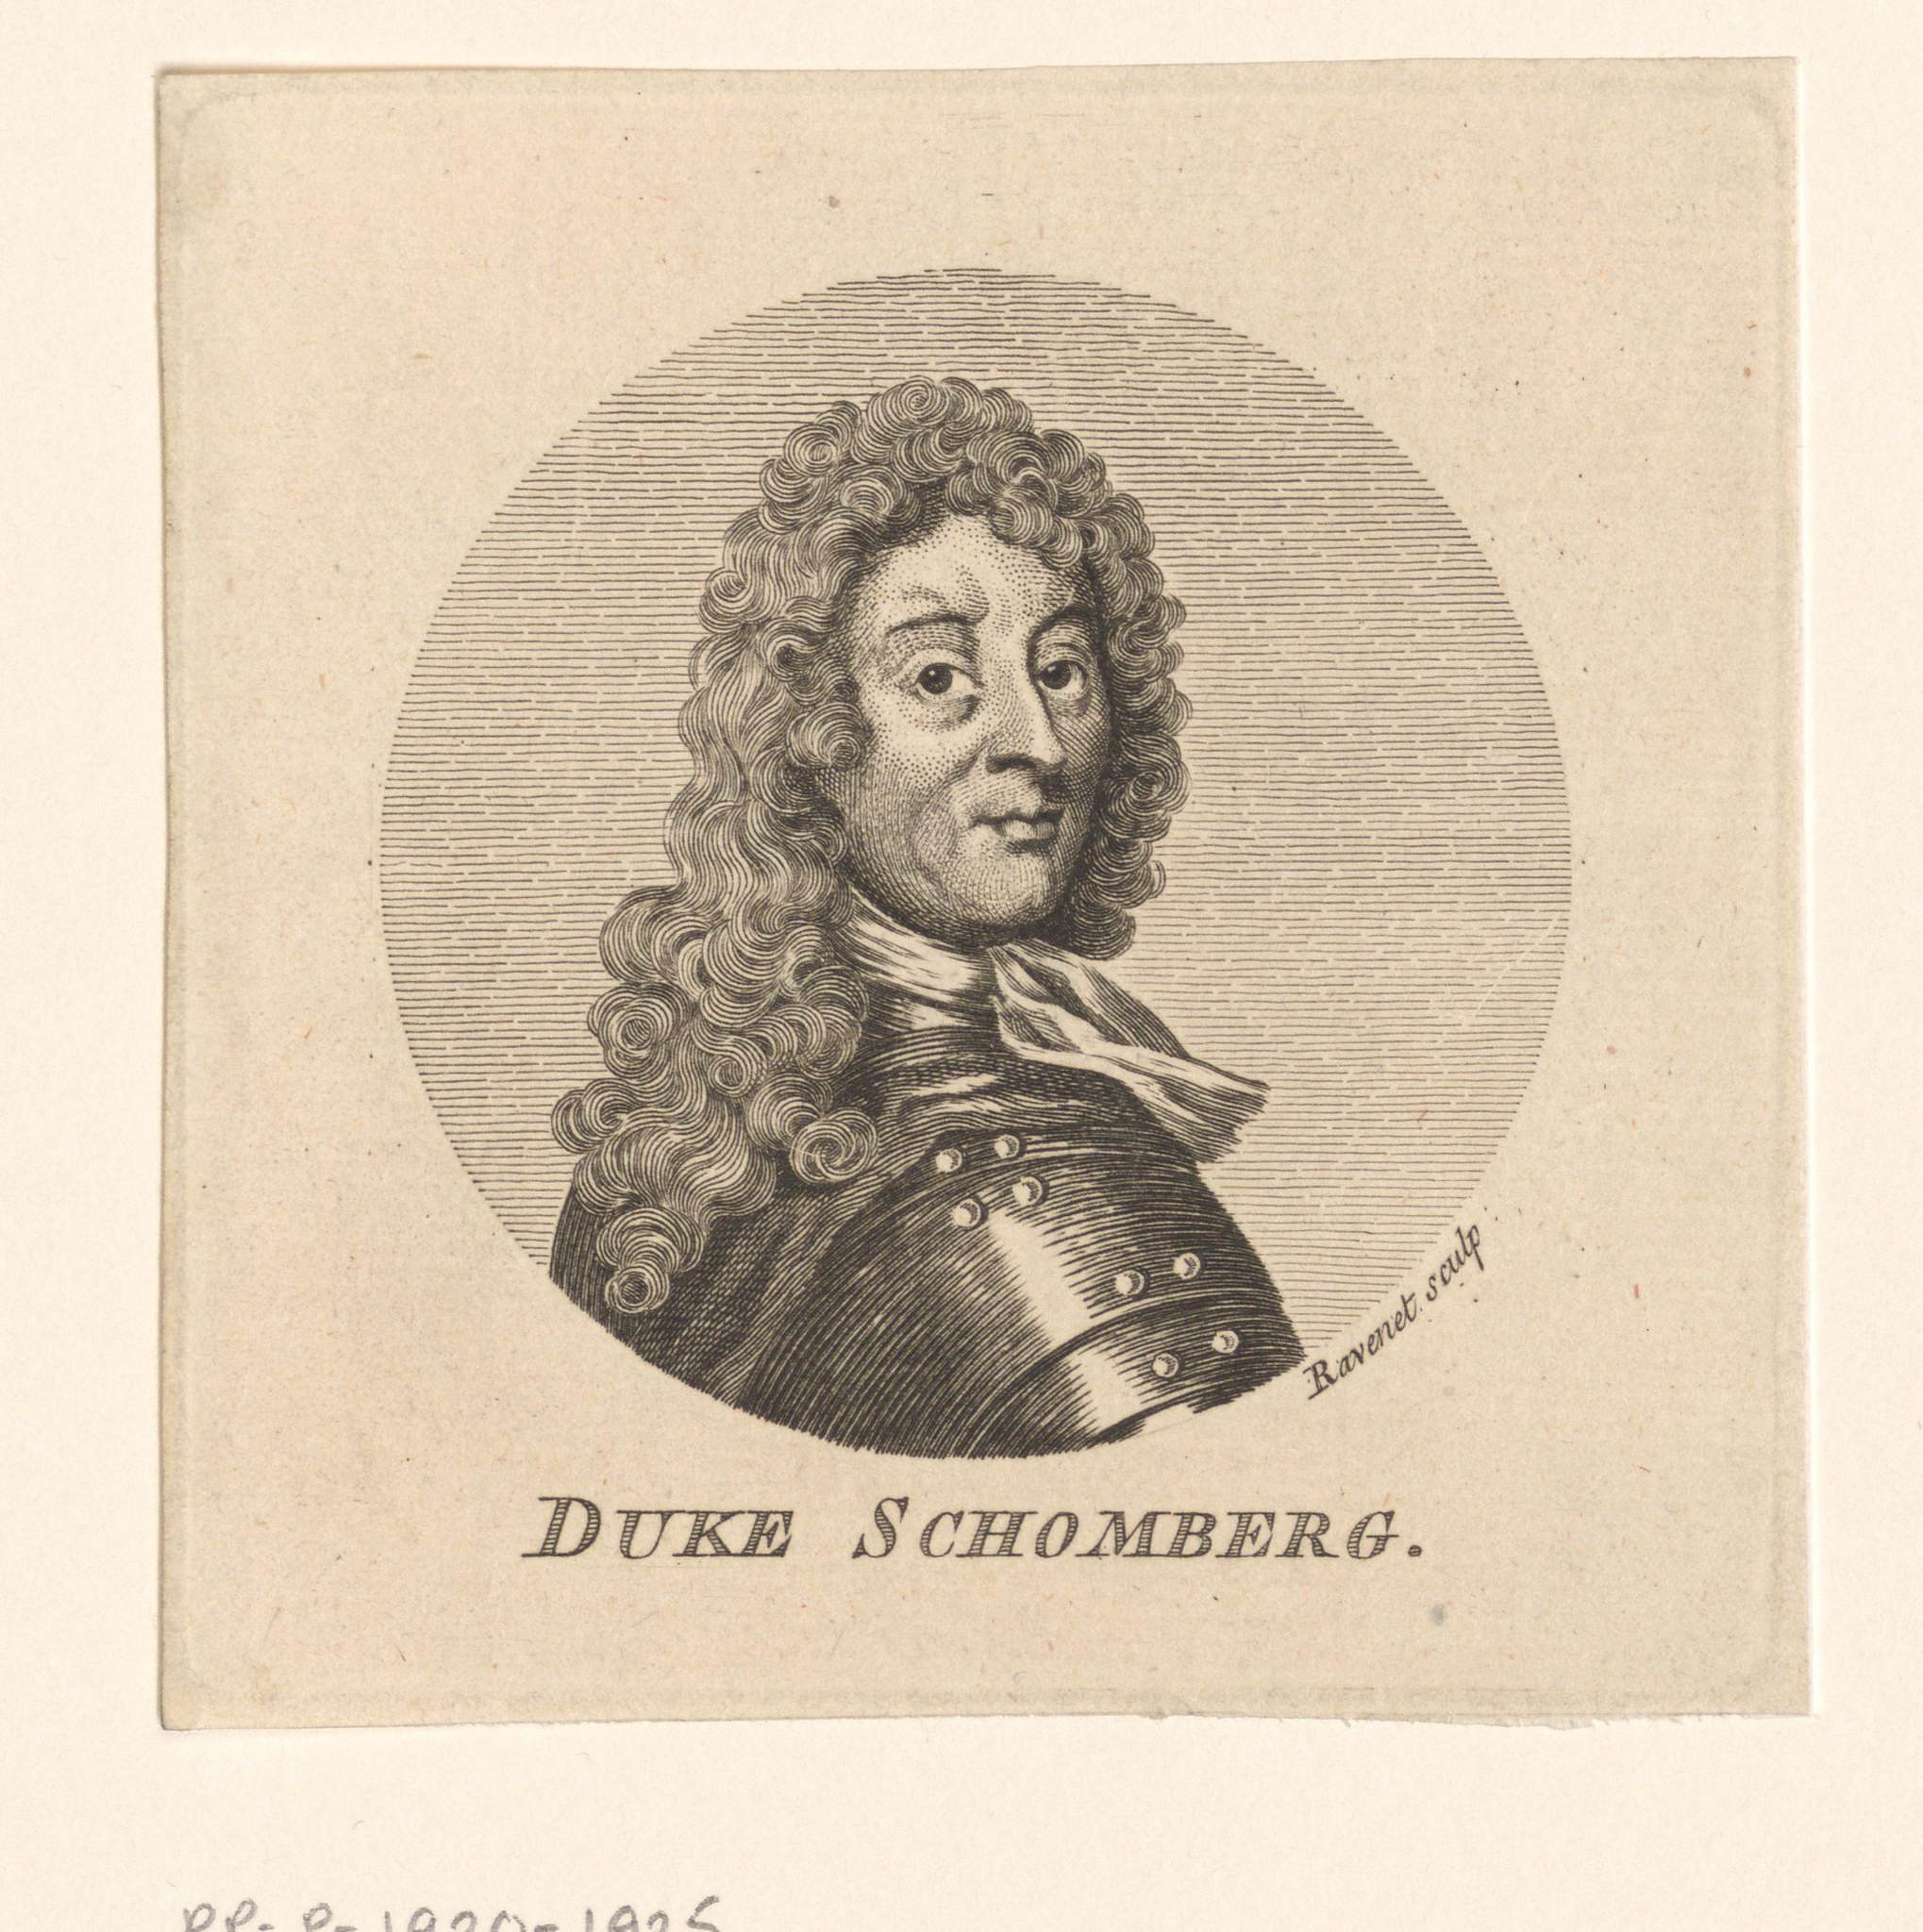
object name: print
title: Portret van hertog Frederik van Schomberg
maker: simon françois ravenet (le vieux)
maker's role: print maker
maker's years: 1706-1774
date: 1758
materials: paper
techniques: engraving, etching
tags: commander-in-chief, general, marshal, historical persons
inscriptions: collector's mark: Lugt 2228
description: Prent waarschijnlijk uit: Smollett, Tobias. A Complete History of England: From the Descent of Julius Caesar (...). derde druk. Londen: James Rivington en James Fletcher, 1758, dl. 8.